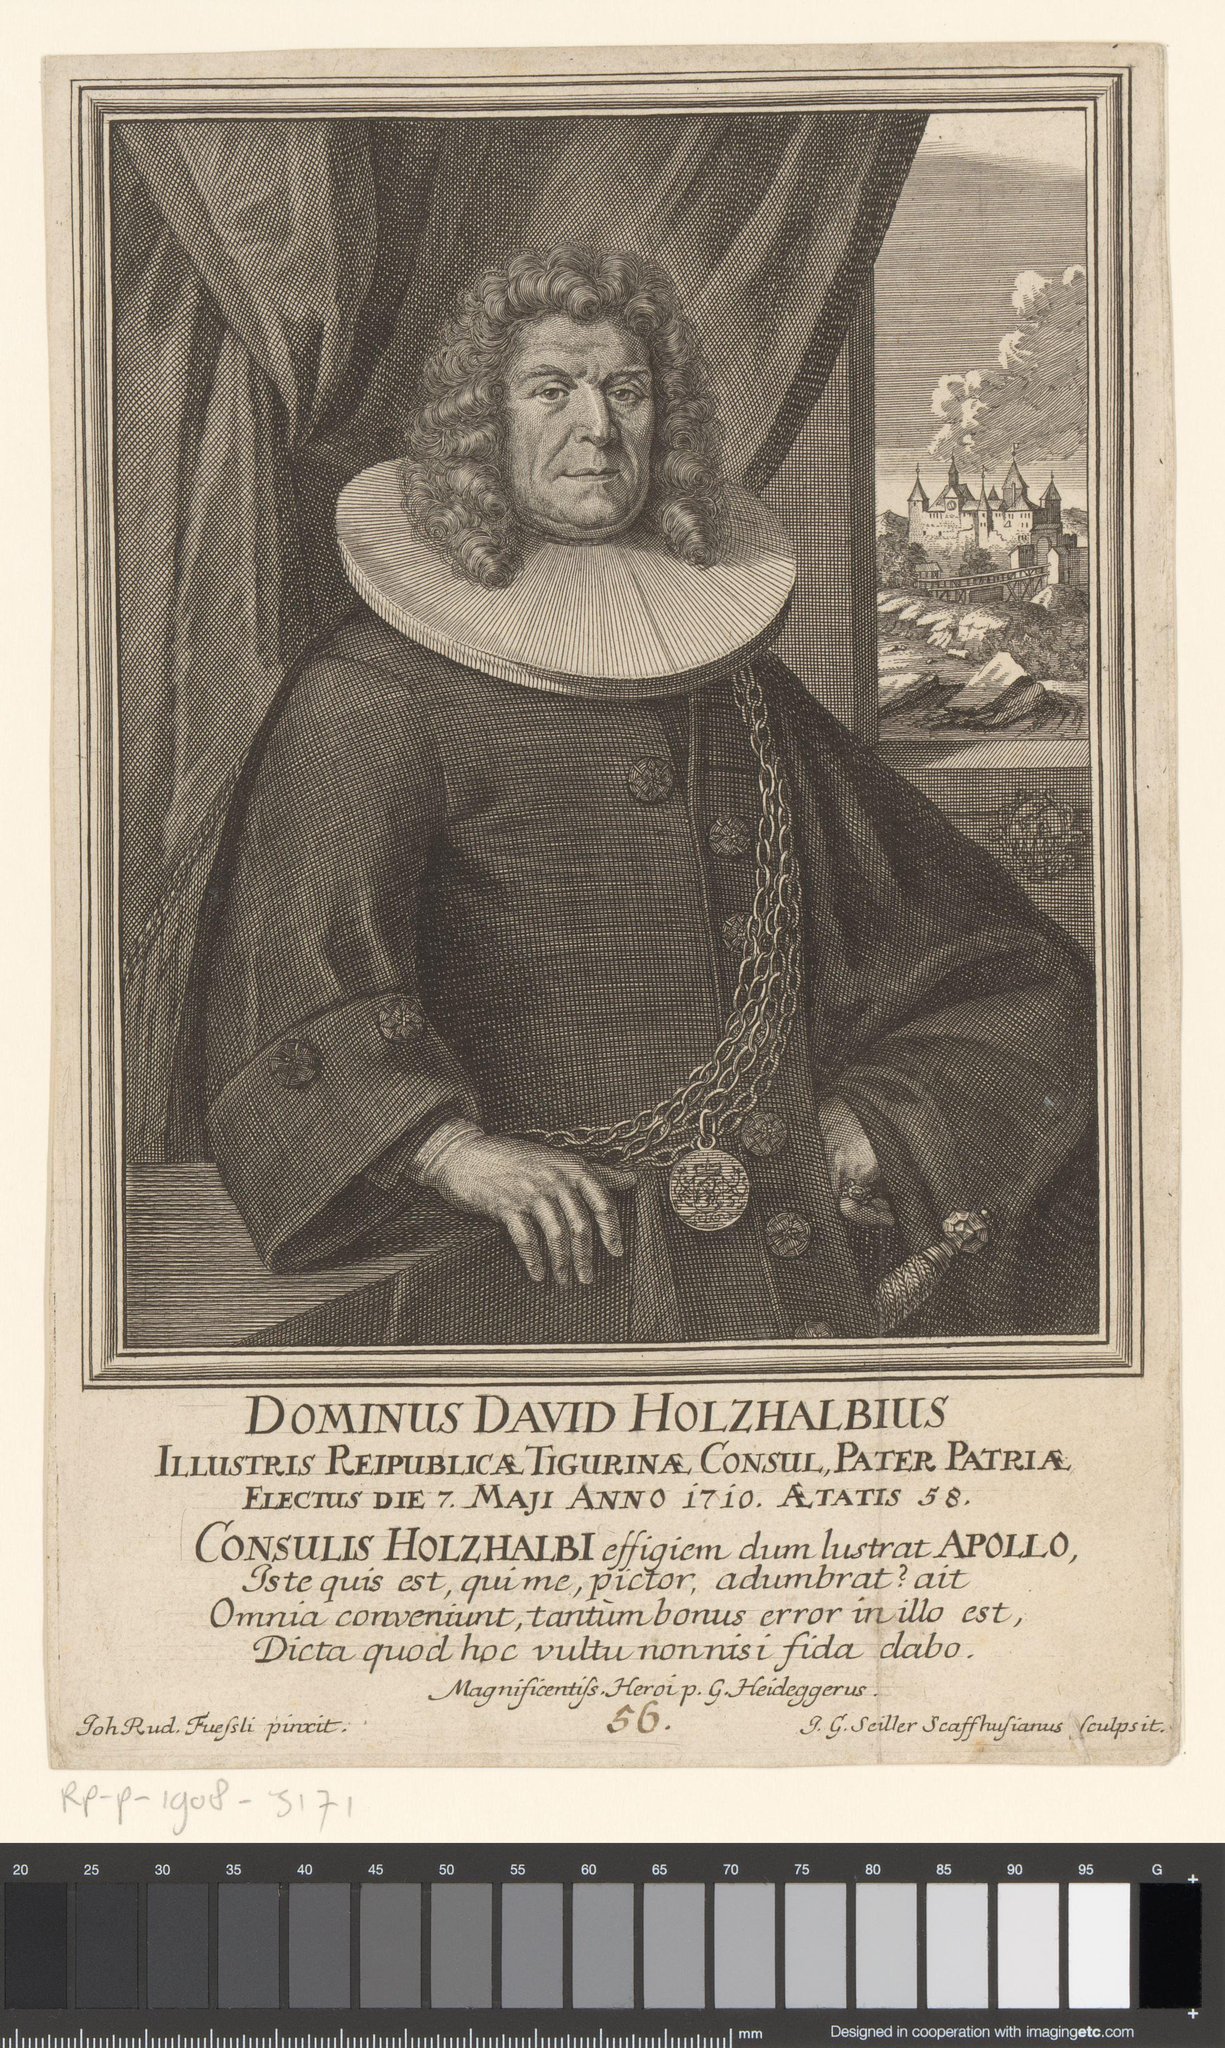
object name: print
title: Portret van David Holzhalb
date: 1673-1740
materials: paper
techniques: engraving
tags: mayor, castle, historical persons, armorial bearing, heraldry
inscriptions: number: ‘56.’, collector's mark: Lugt 2228